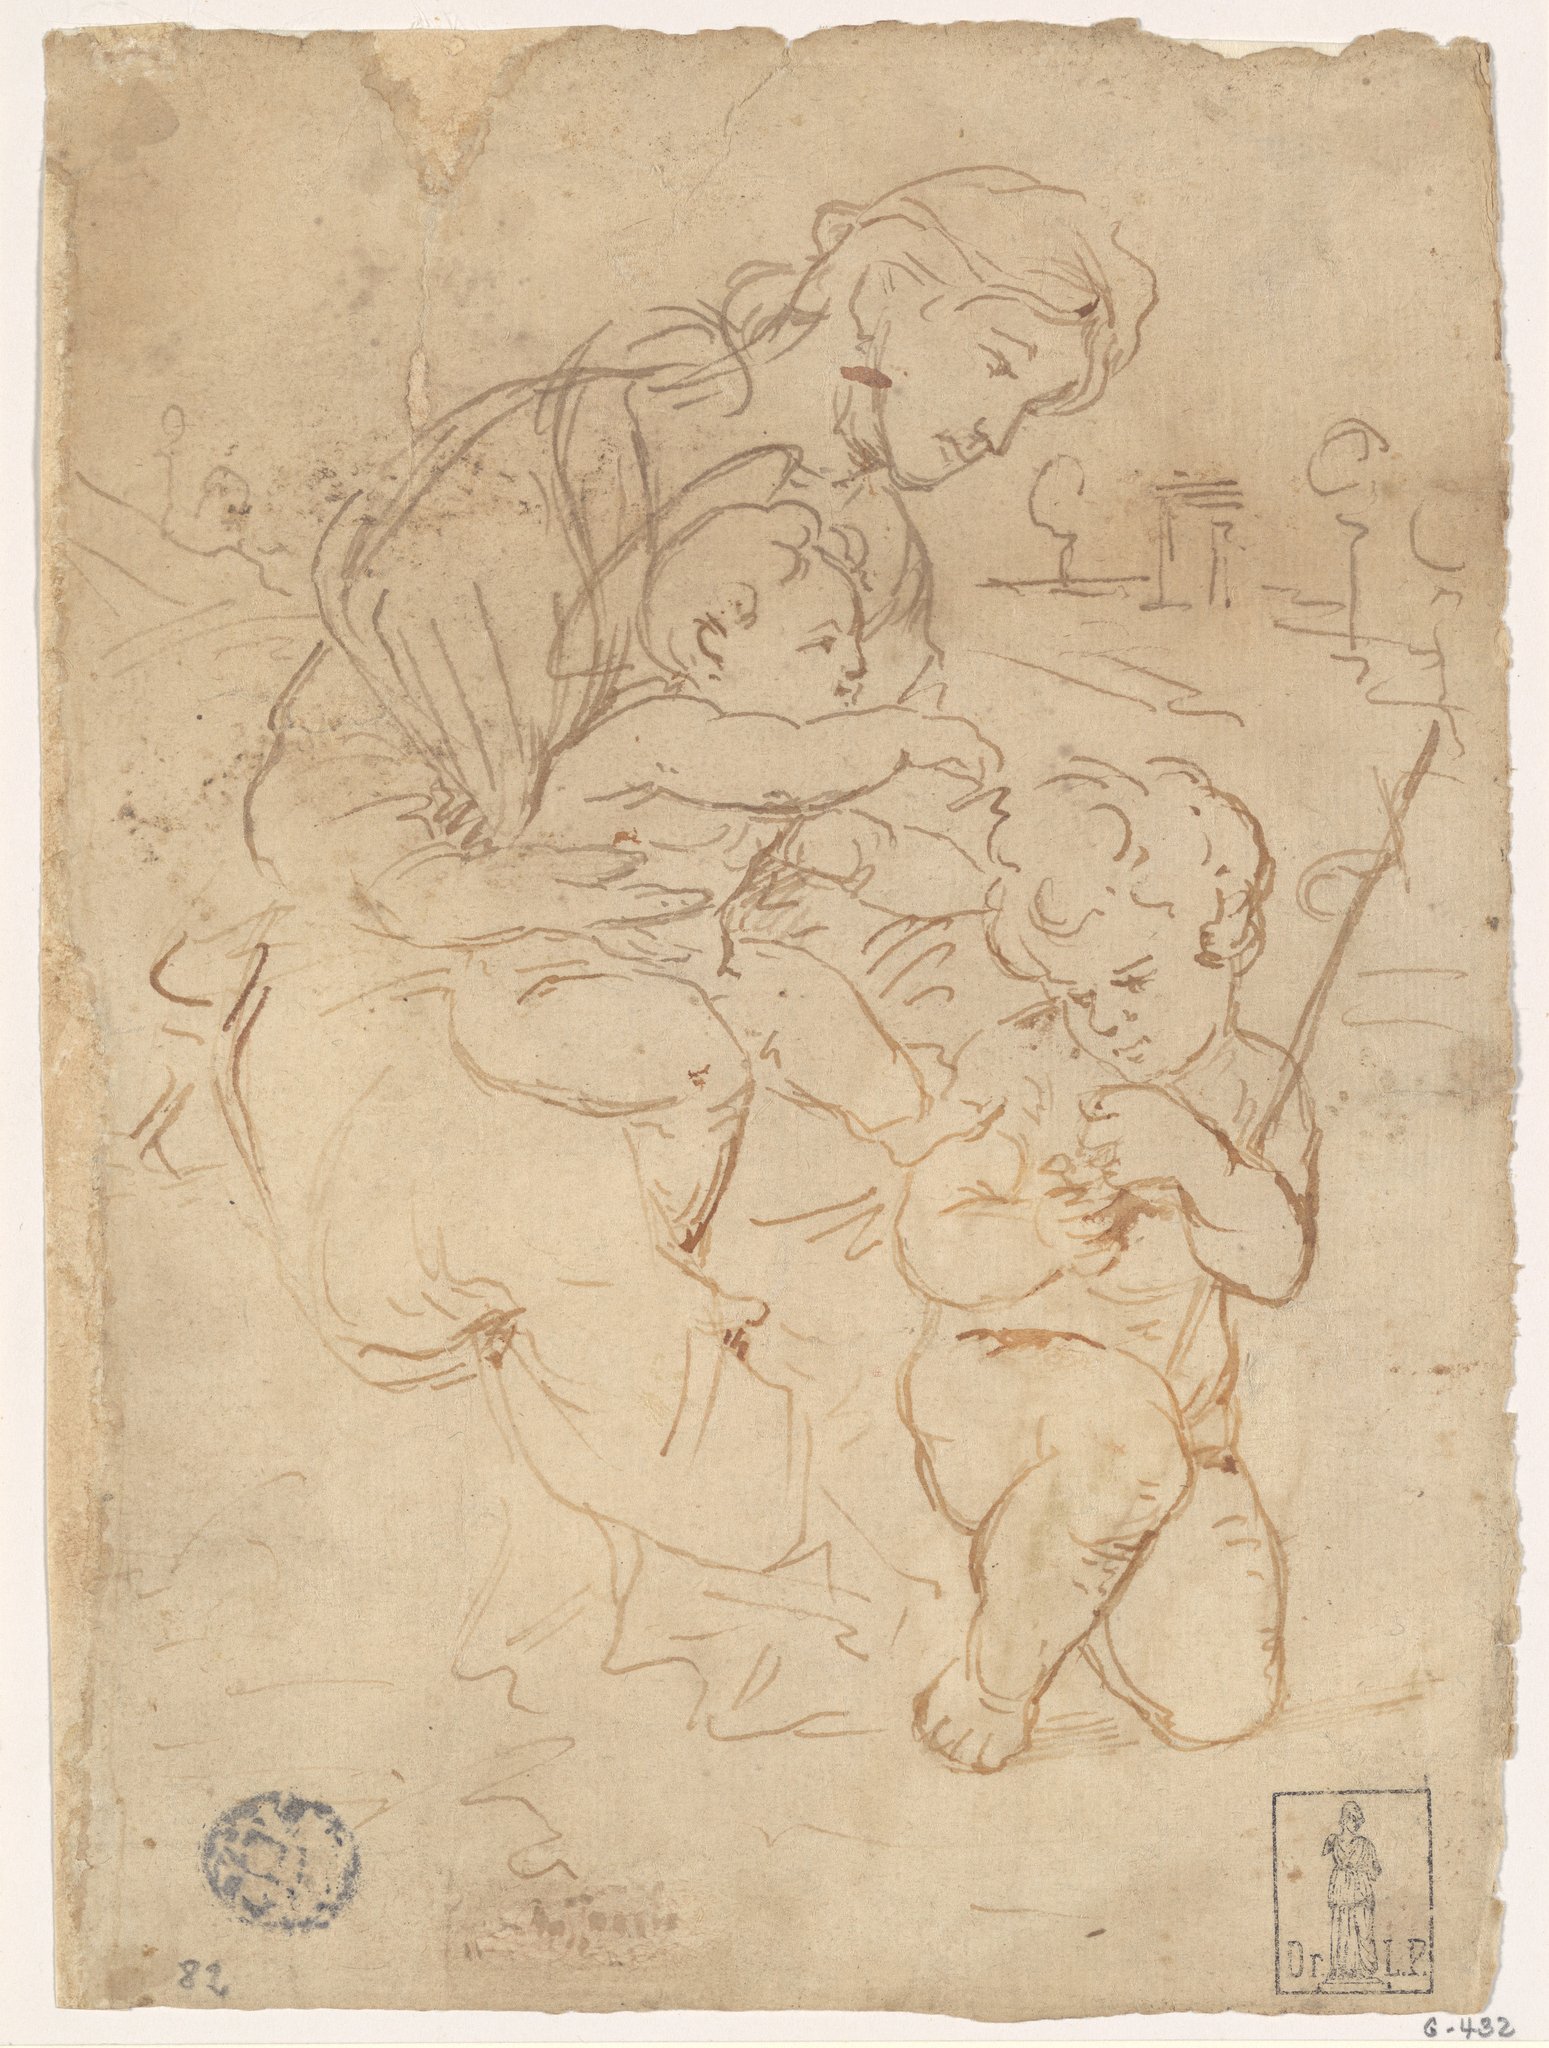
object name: drawing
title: Madonna and Child with the Young Saint John the Baptist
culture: italian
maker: italy, in the manner of raphael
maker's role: artist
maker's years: 1770-1829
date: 1767-1833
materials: ink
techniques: pen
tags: madonna and child,saint john the baptist